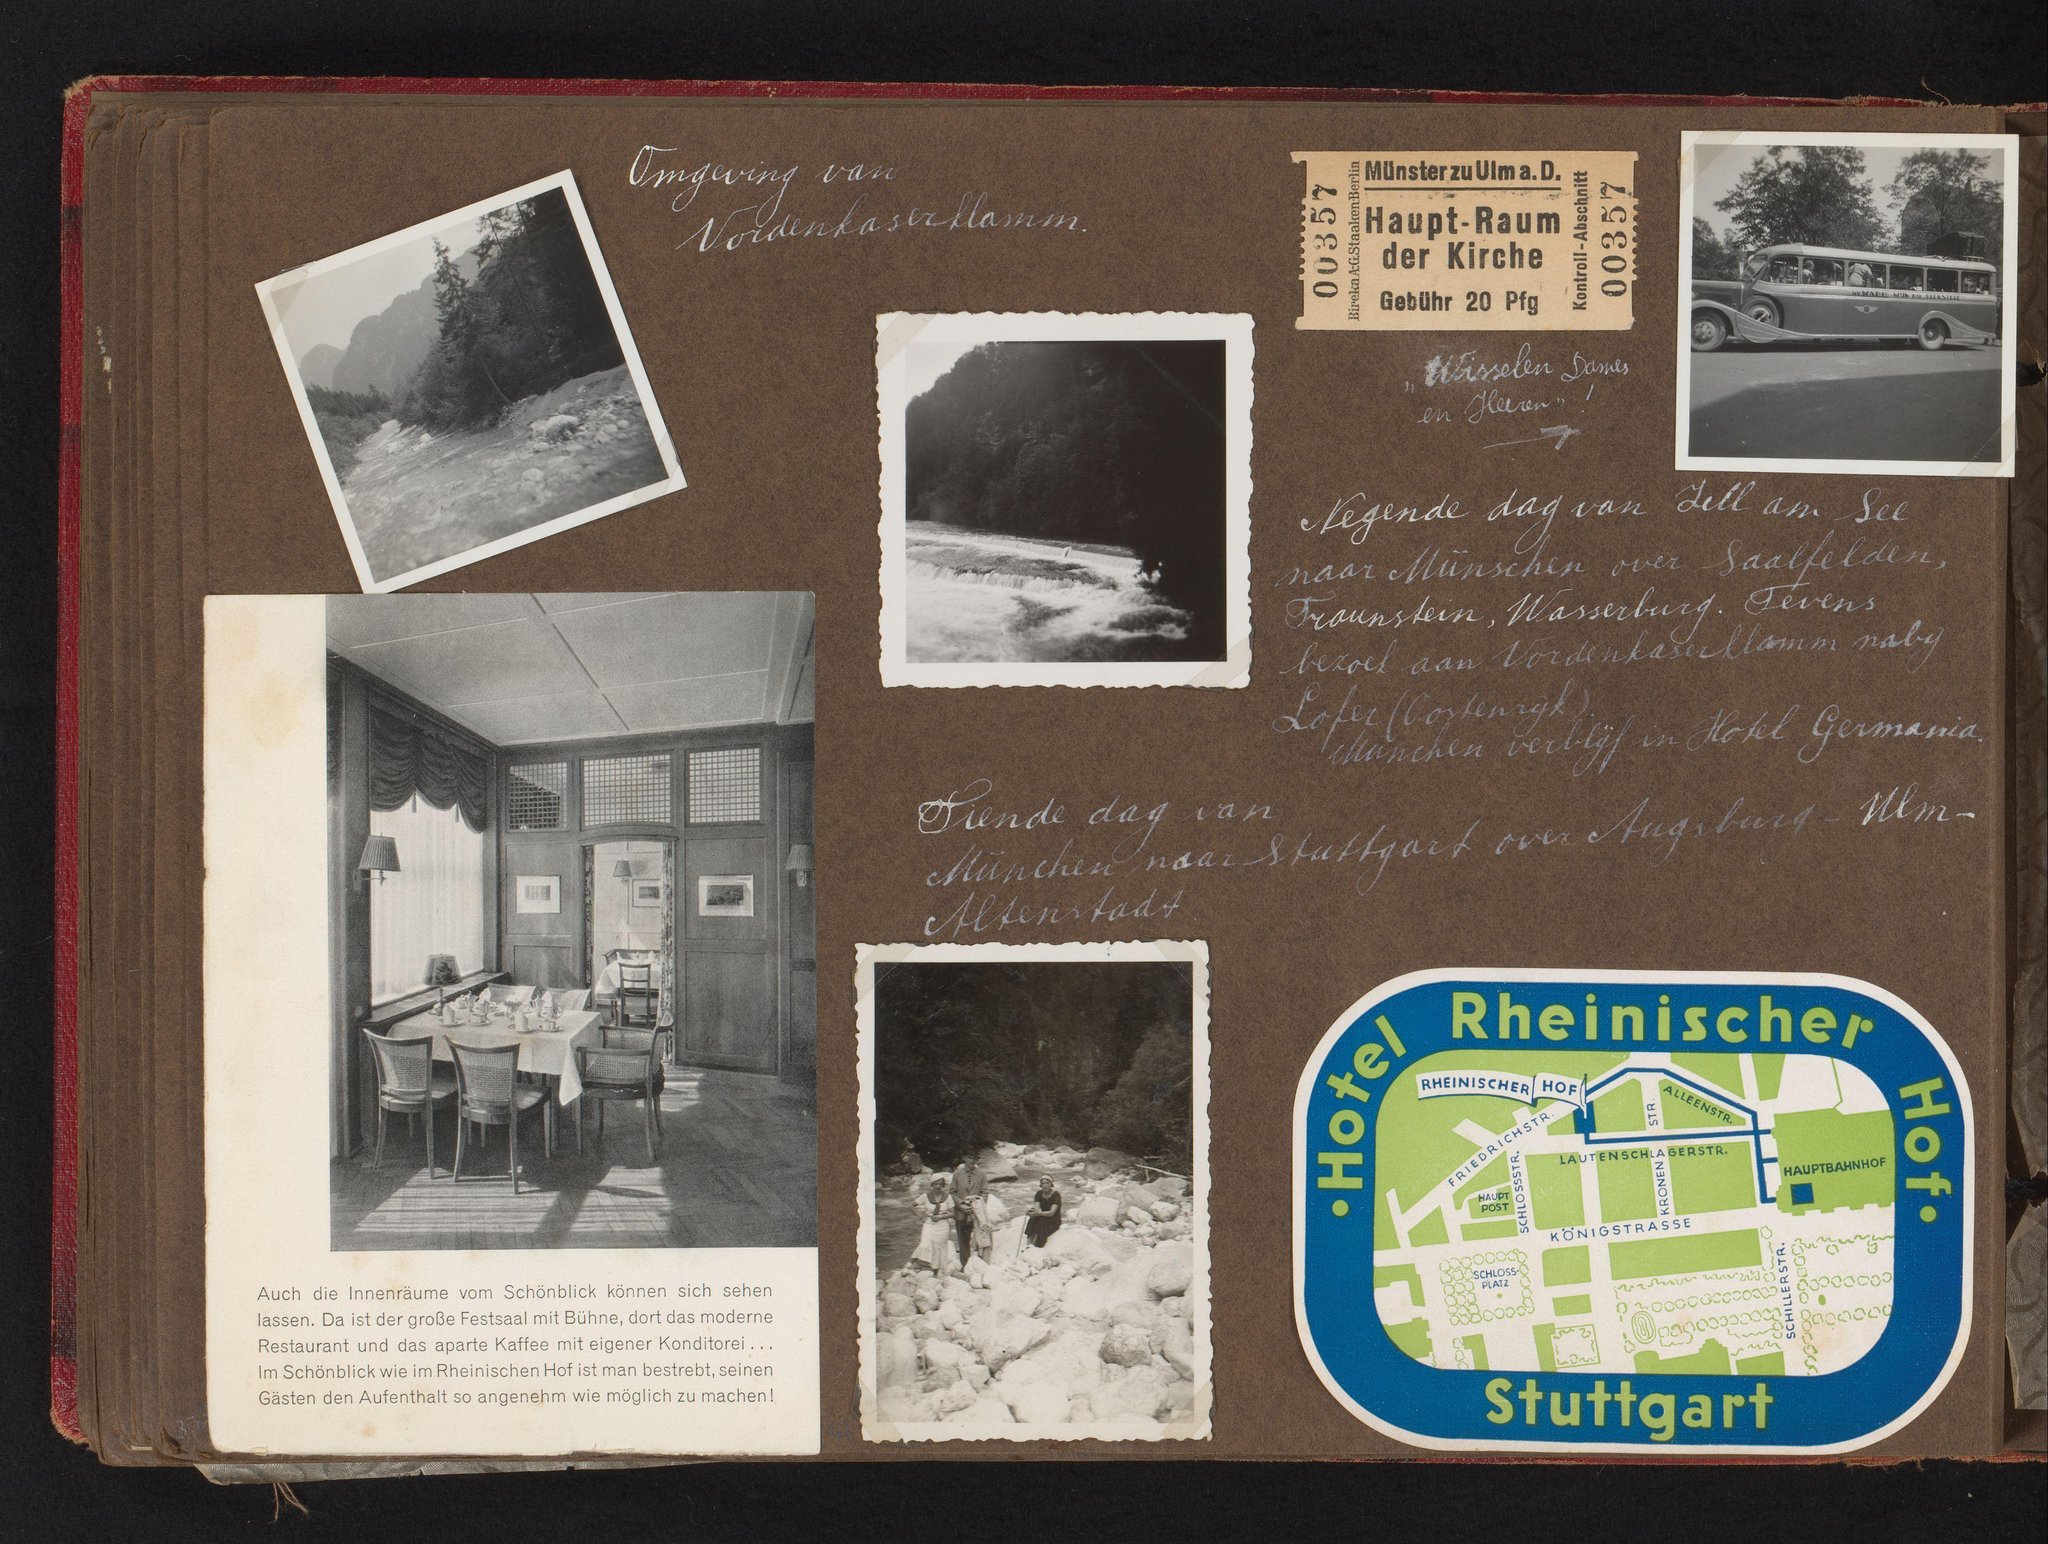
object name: folder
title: Negende dag van Zell am See naar München ... / Tiende dag van München naar Stuttgart ...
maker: Anonymous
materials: paper, photographic support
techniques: gelatin silver print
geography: germany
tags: outing, pleasure trip, hotel, hostelry, inn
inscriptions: inscription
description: Albumblad met vier foto's van landschappen en een autobus onderweg en afbeeldingen van het hotel in Stuttgart. Verslag van een twaalfdaagse groepsreis per autobus naar Salzburgerland en Beieren van 30 juli tot 10 augustus 1936. Onderdeel van het reisalbum van de familie Van den Broek 1935-1937.